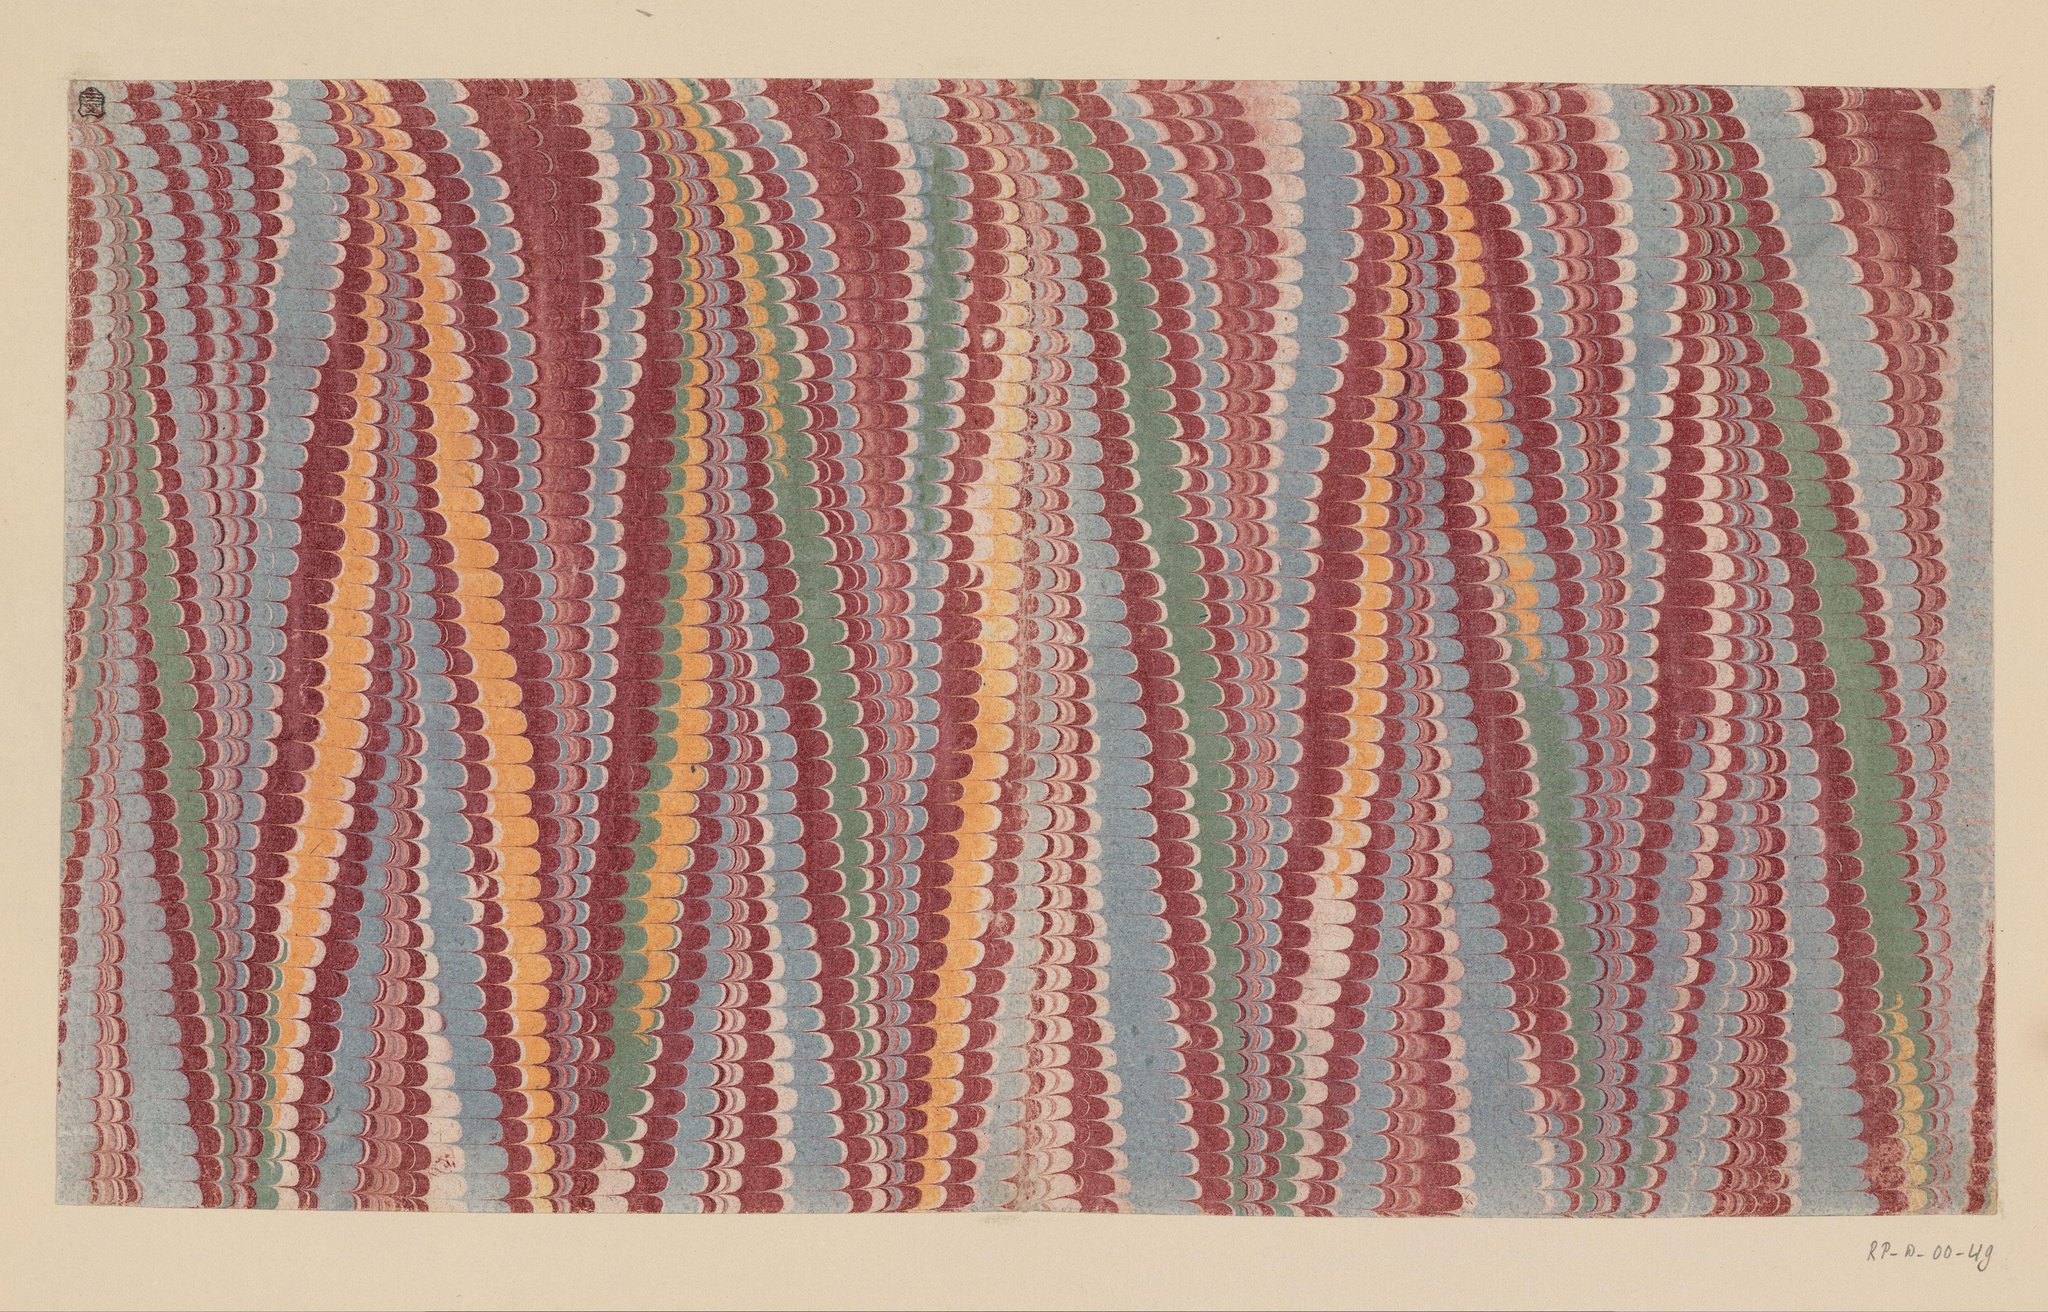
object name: marbled paper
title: Kammarmer in rood, geel, blauw en groen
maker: Anonymous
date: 1700-1850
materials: paint, paper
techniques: marbled paper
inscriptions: collector's mark: Lugt 2760